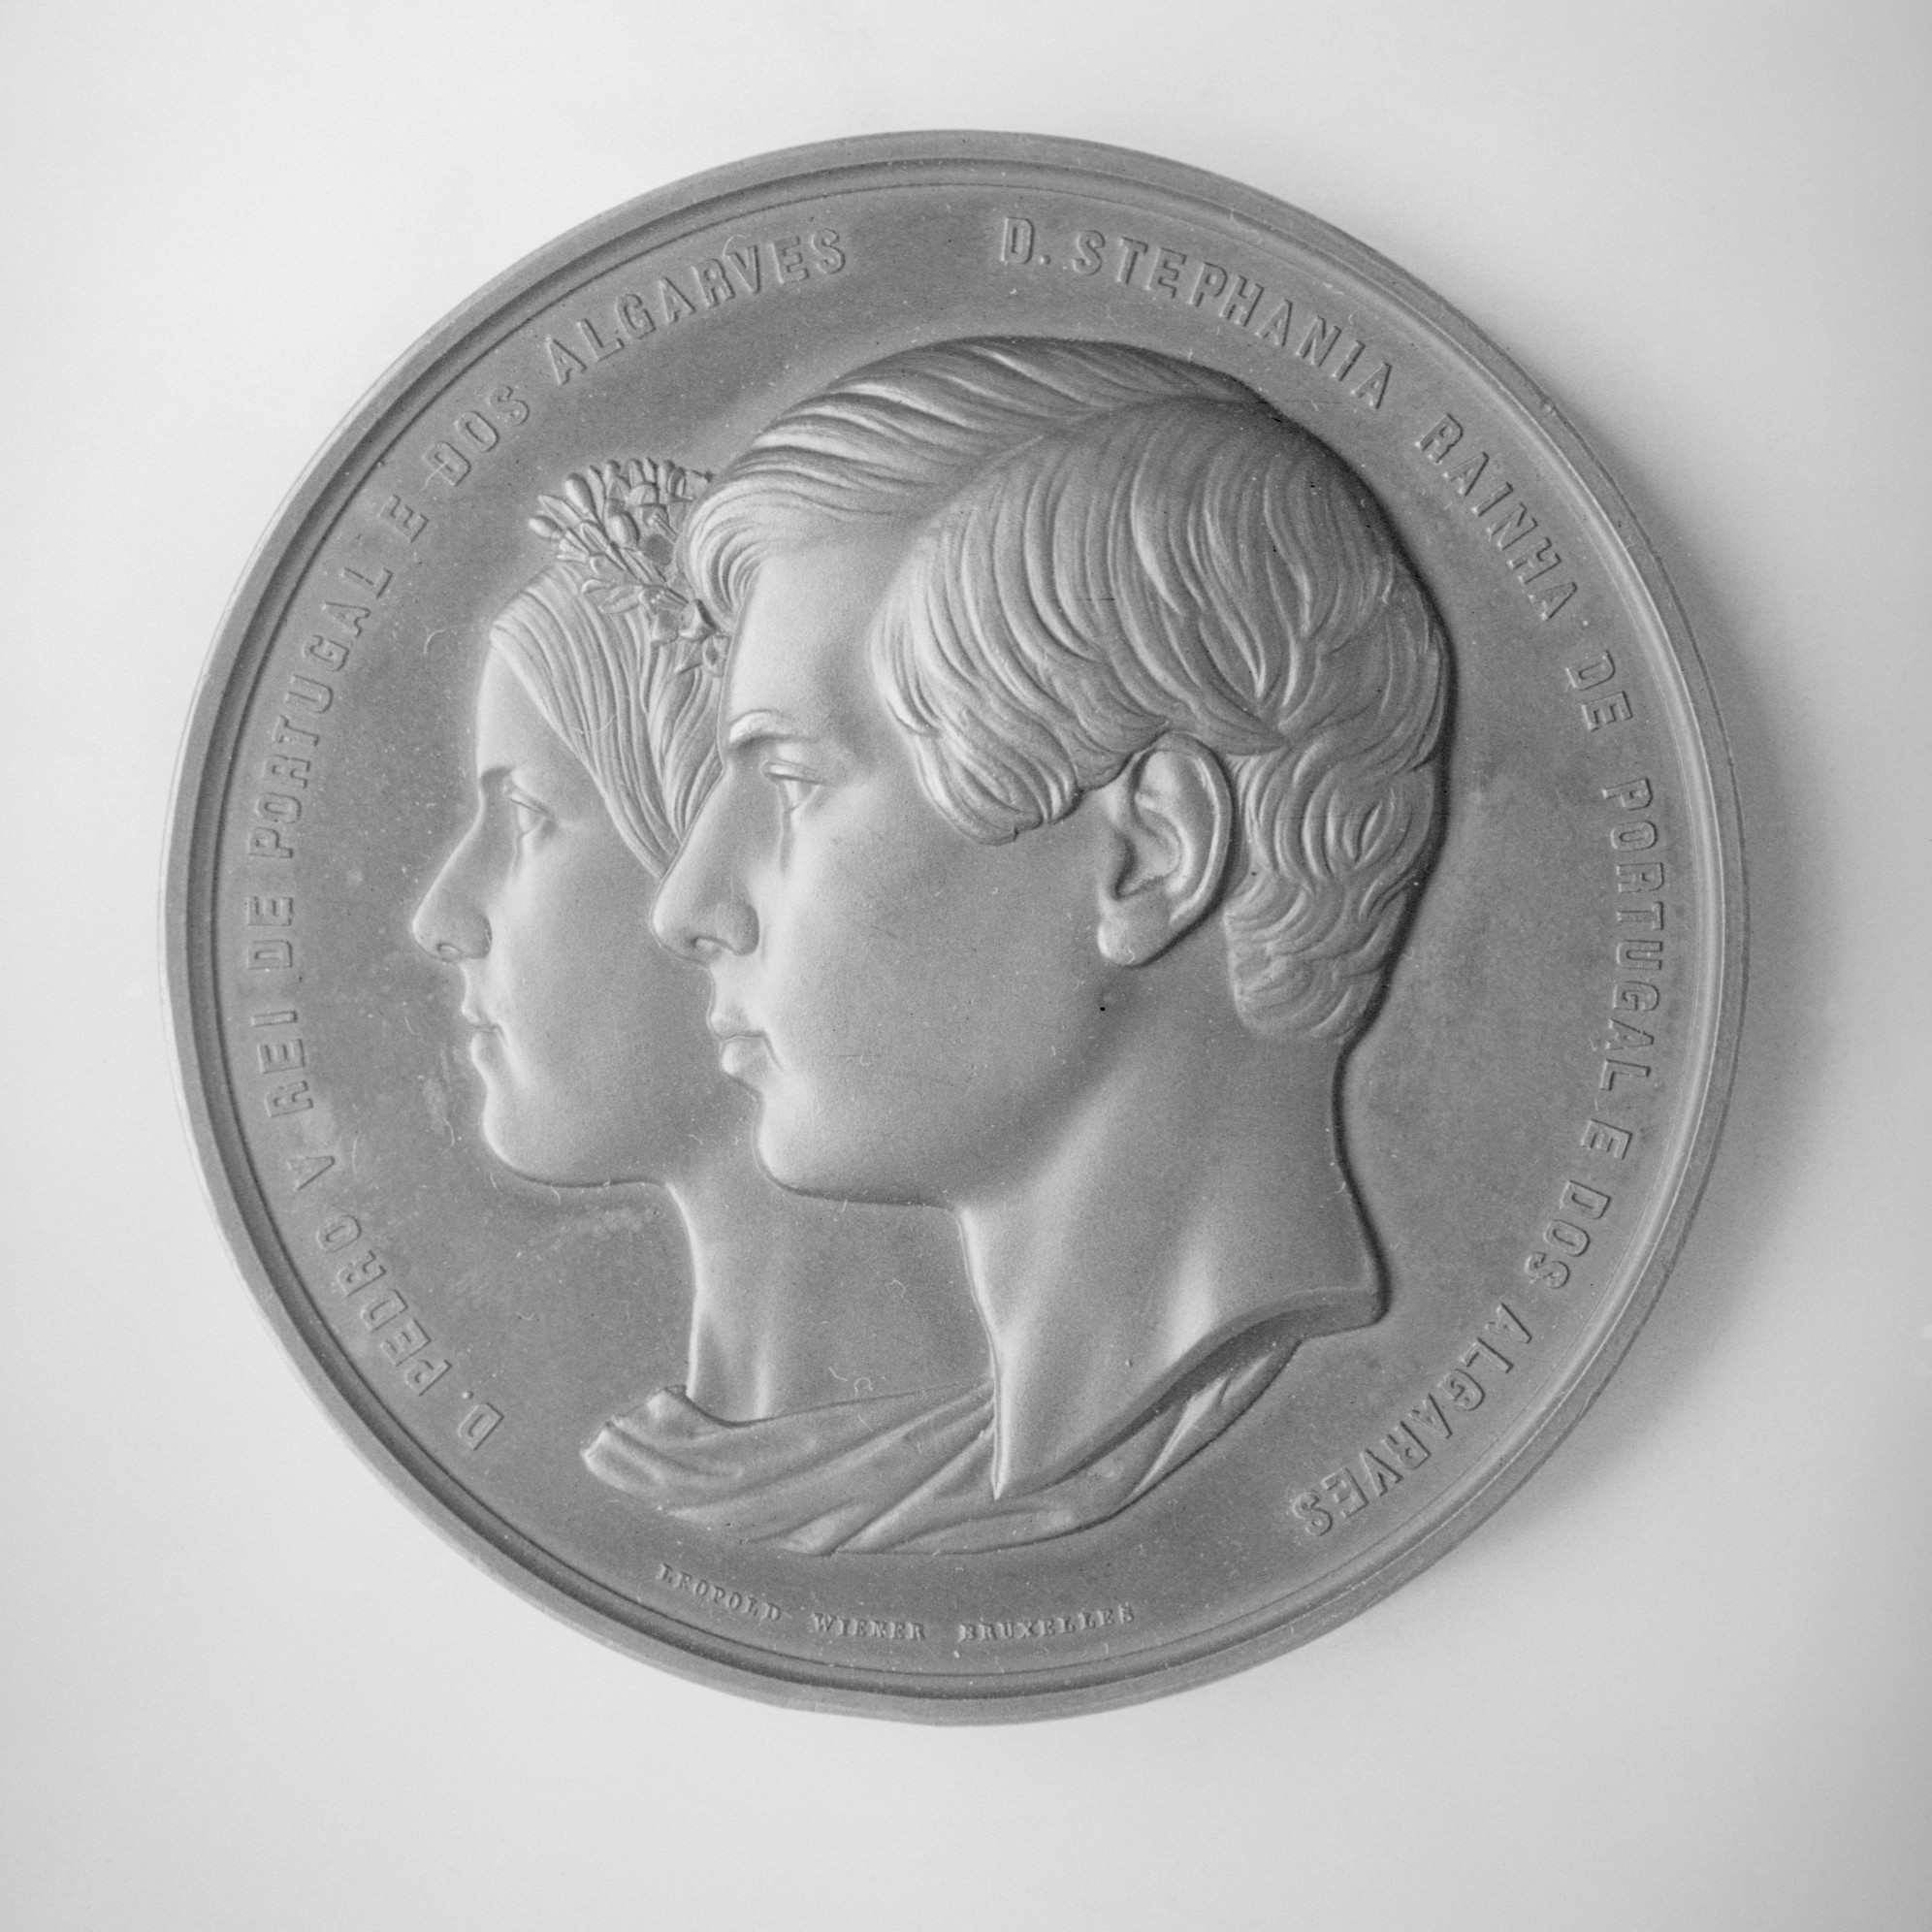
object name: medal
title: Marriage of Pedro V, King of Portugal (1837–1861) and Stephanie, Queen of Portugal (1837–1859)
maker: leopold wiener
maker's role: artist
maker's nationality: belgian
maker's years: 1823-1891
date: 1858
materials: bronze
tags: kings,queens,profiles,women